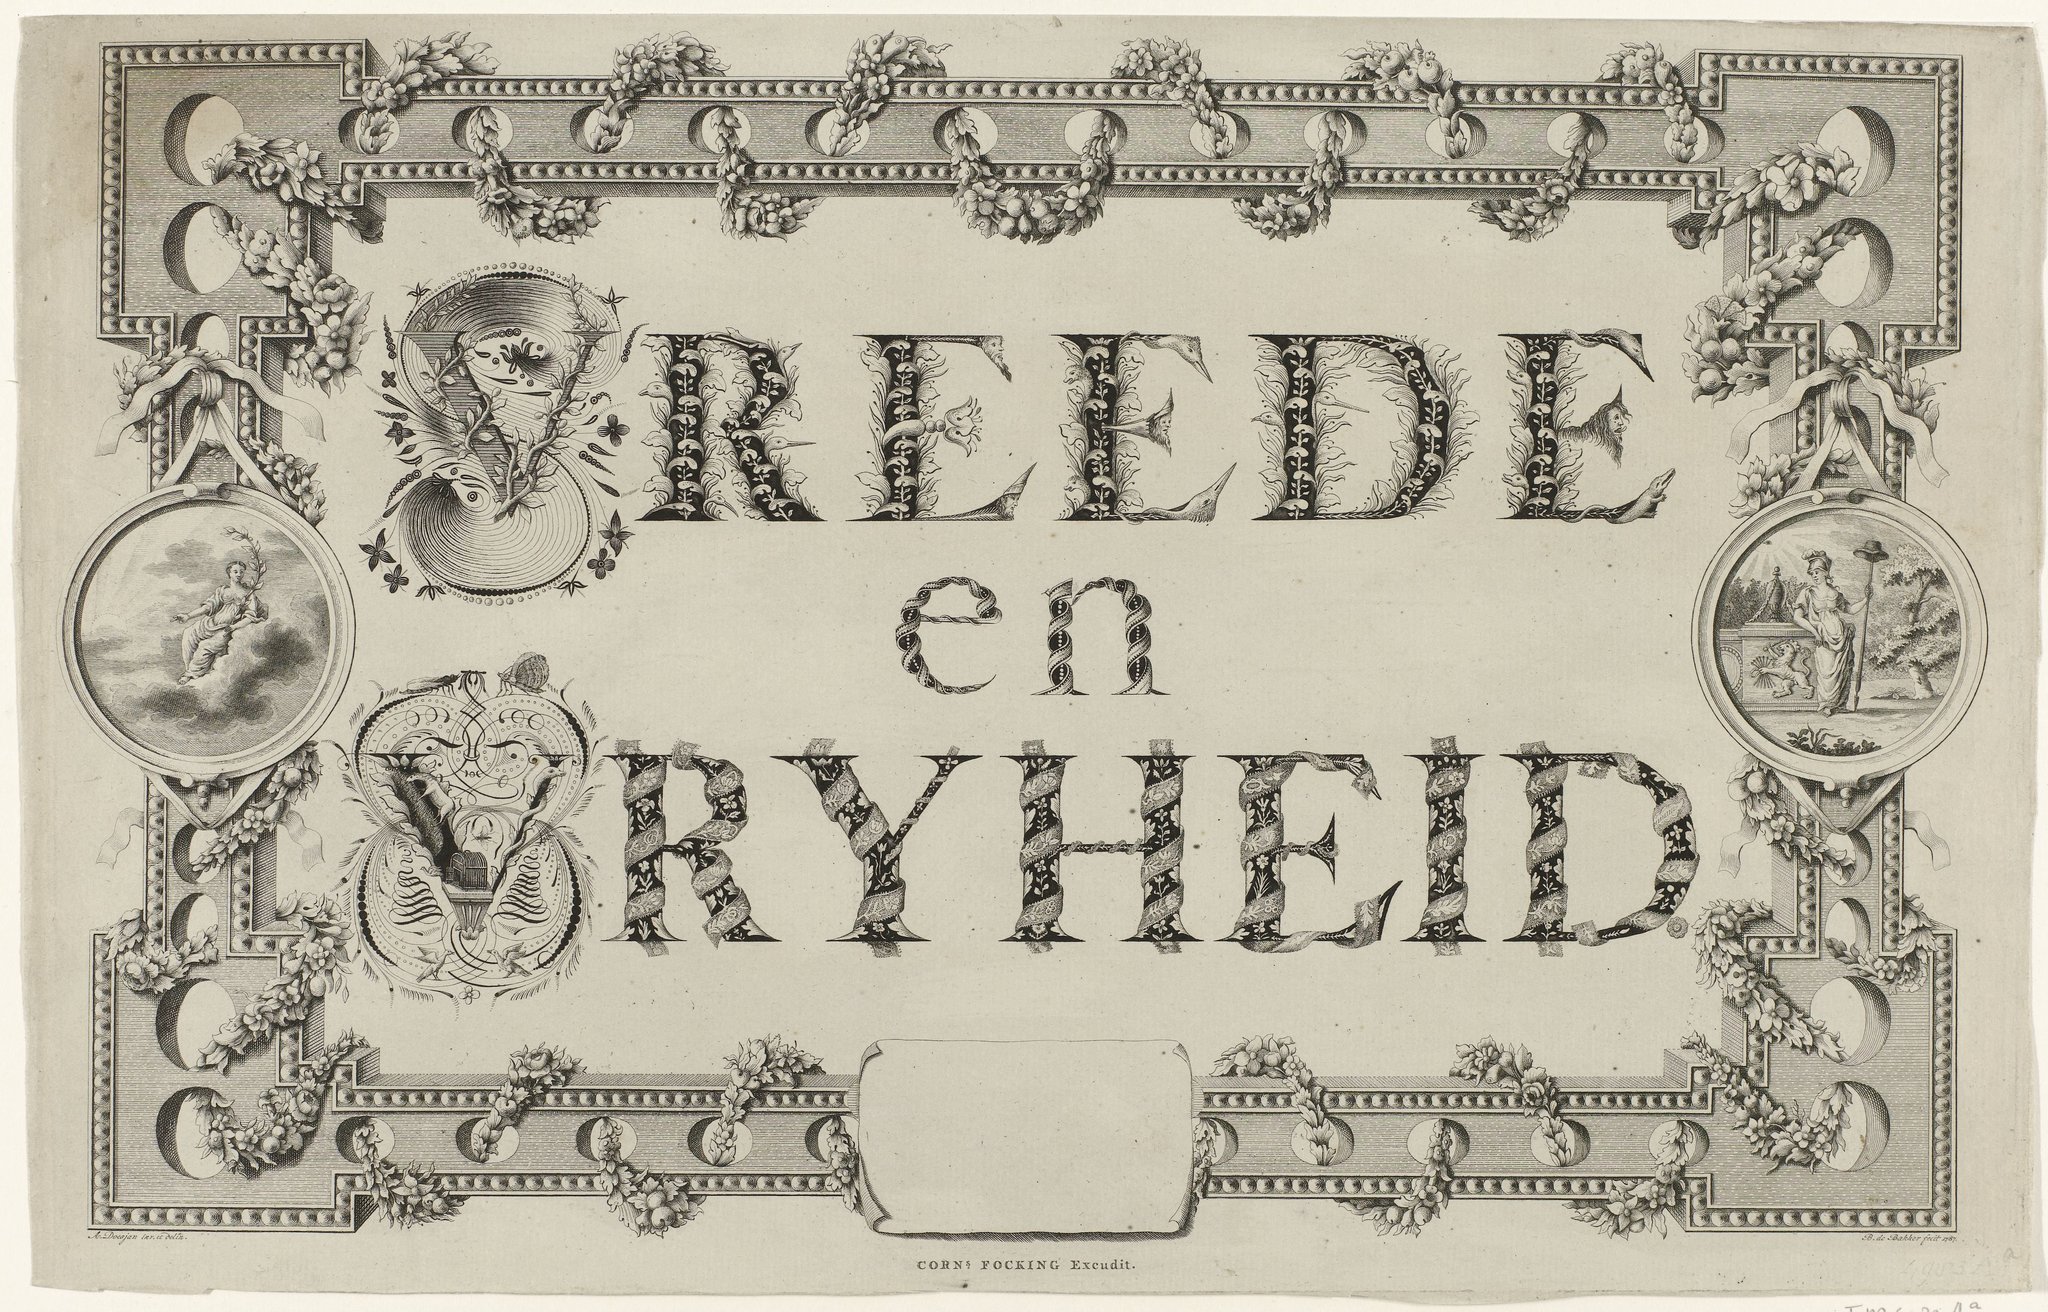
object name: calligraphy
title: Kalligrafie op de vrede en vrijheid, 1787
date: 1787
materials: paper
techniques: engraving, etching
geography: northern netherlands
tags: symbols, allegories of peace, 'pax'; 'pace' (ripa), calligraphy, freedom, liberty; 'libertà' (ripa) (+ abstract concept represented by female figure), netherlands, patriots (1780-1795)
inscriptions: collector's mark: Lugt 2228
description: Kalligrafische allegorie op de vrede en vrijheid in het land, 1787. Met twee allegorische medaillons met de Vrede en de Vrijheid. Zie ook de pendant.